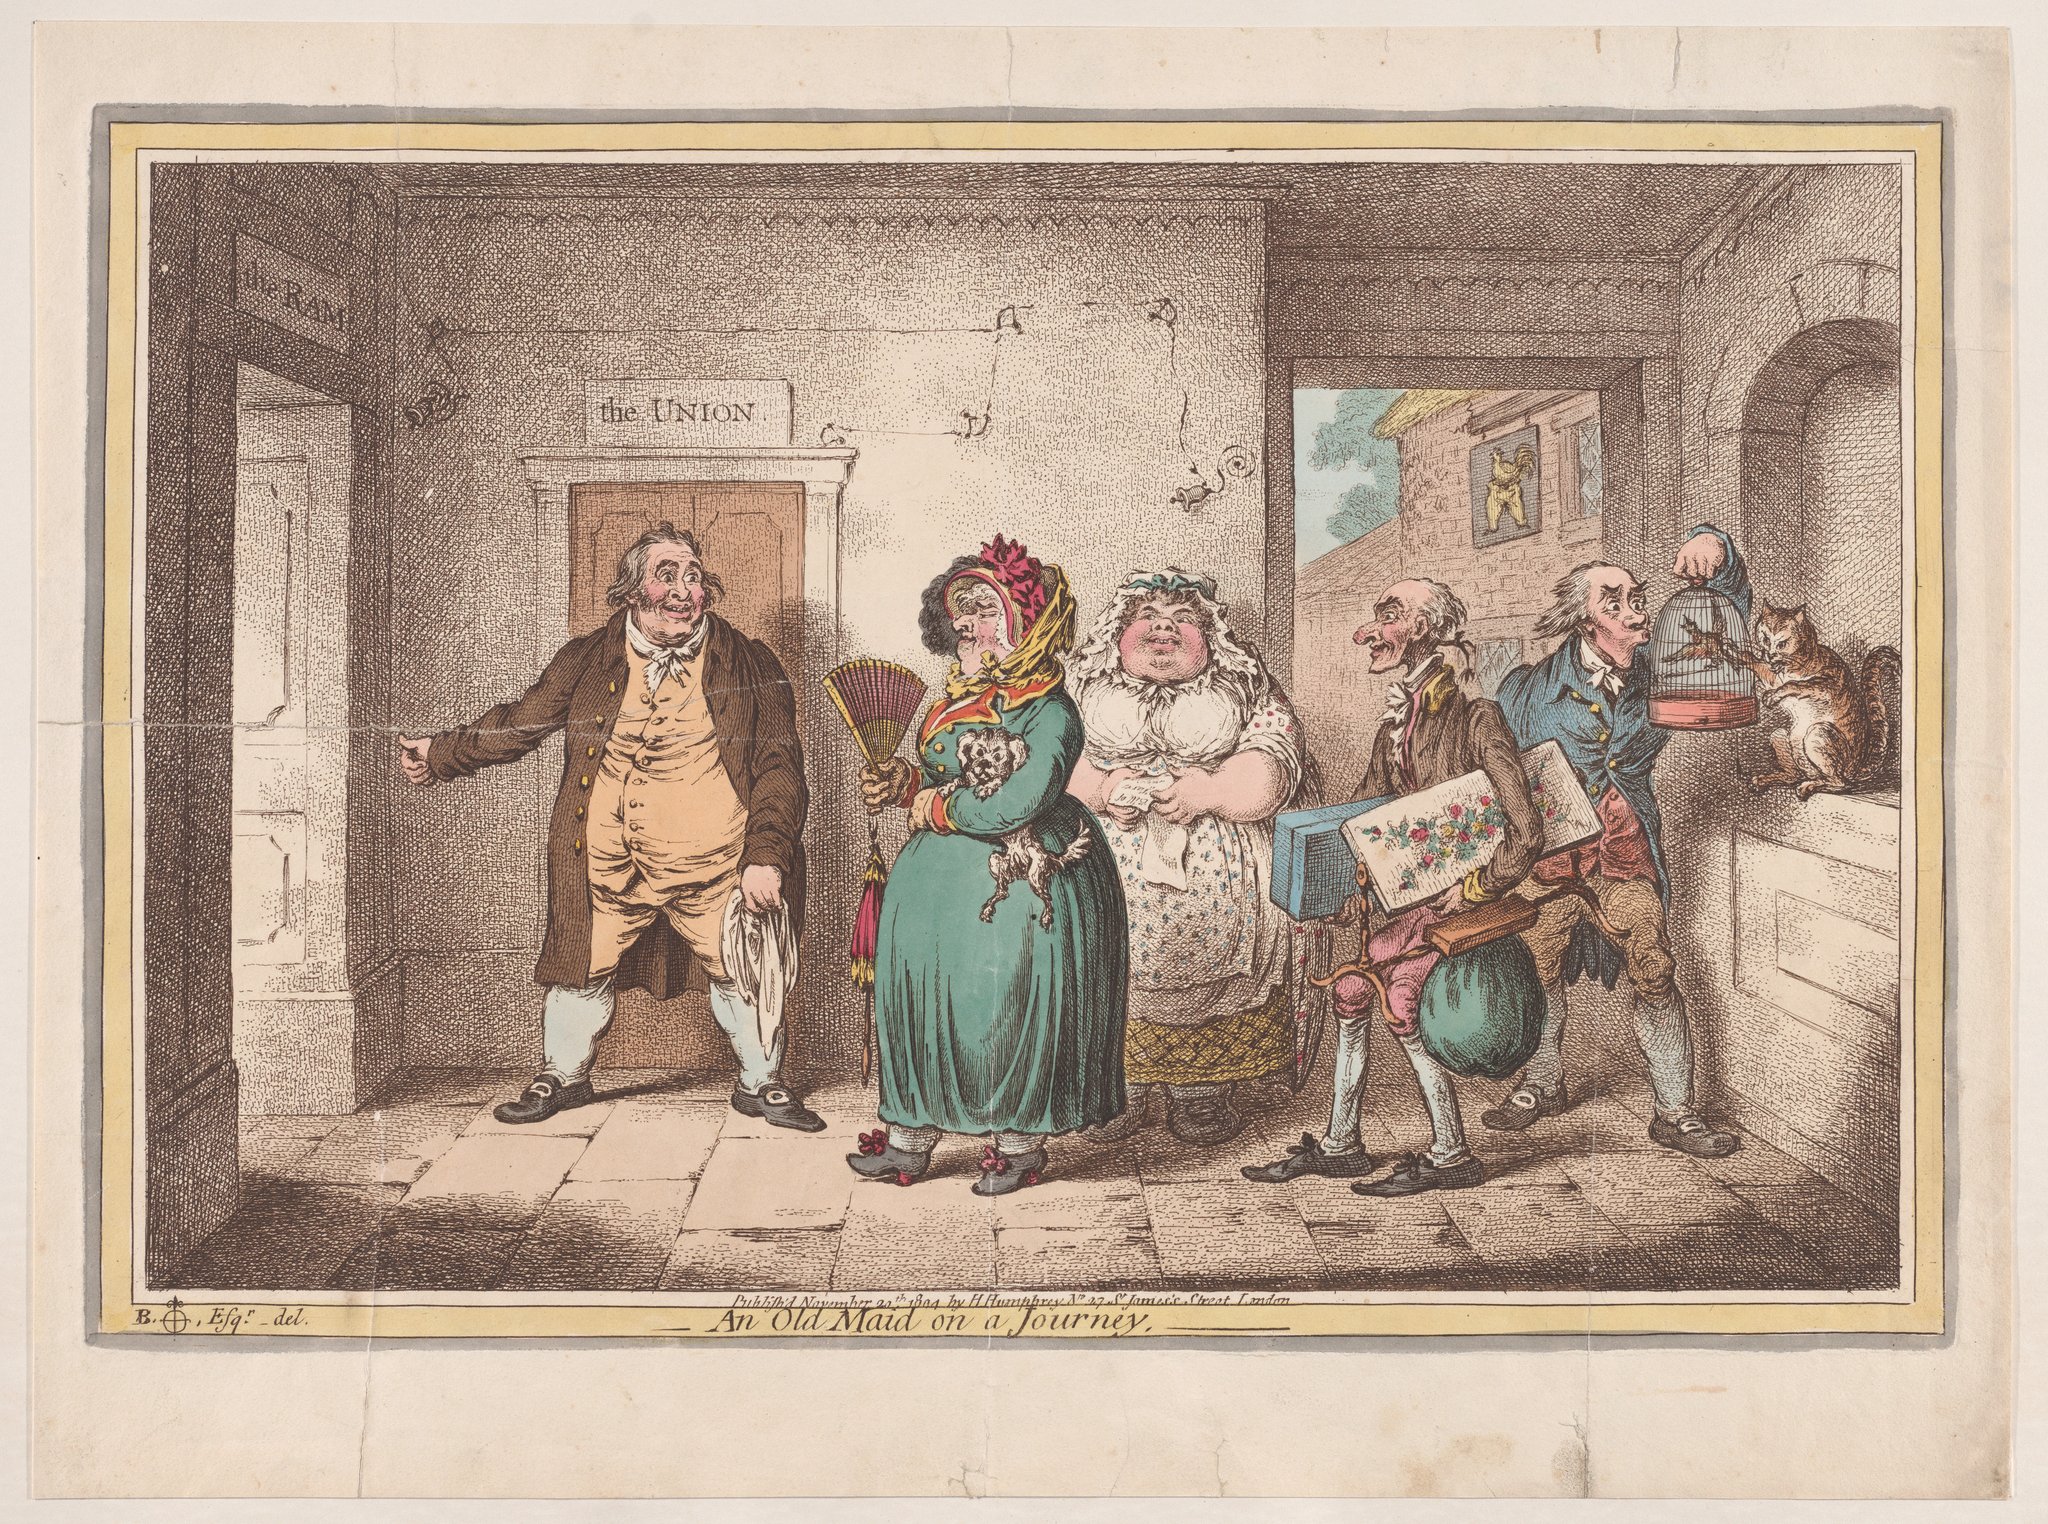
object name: print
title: An Old Maid on a Journey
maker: james gillray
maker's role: artist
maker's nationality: british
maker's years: 1756-1815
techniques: etching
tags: satire,men,women,cats,dogs,caricature